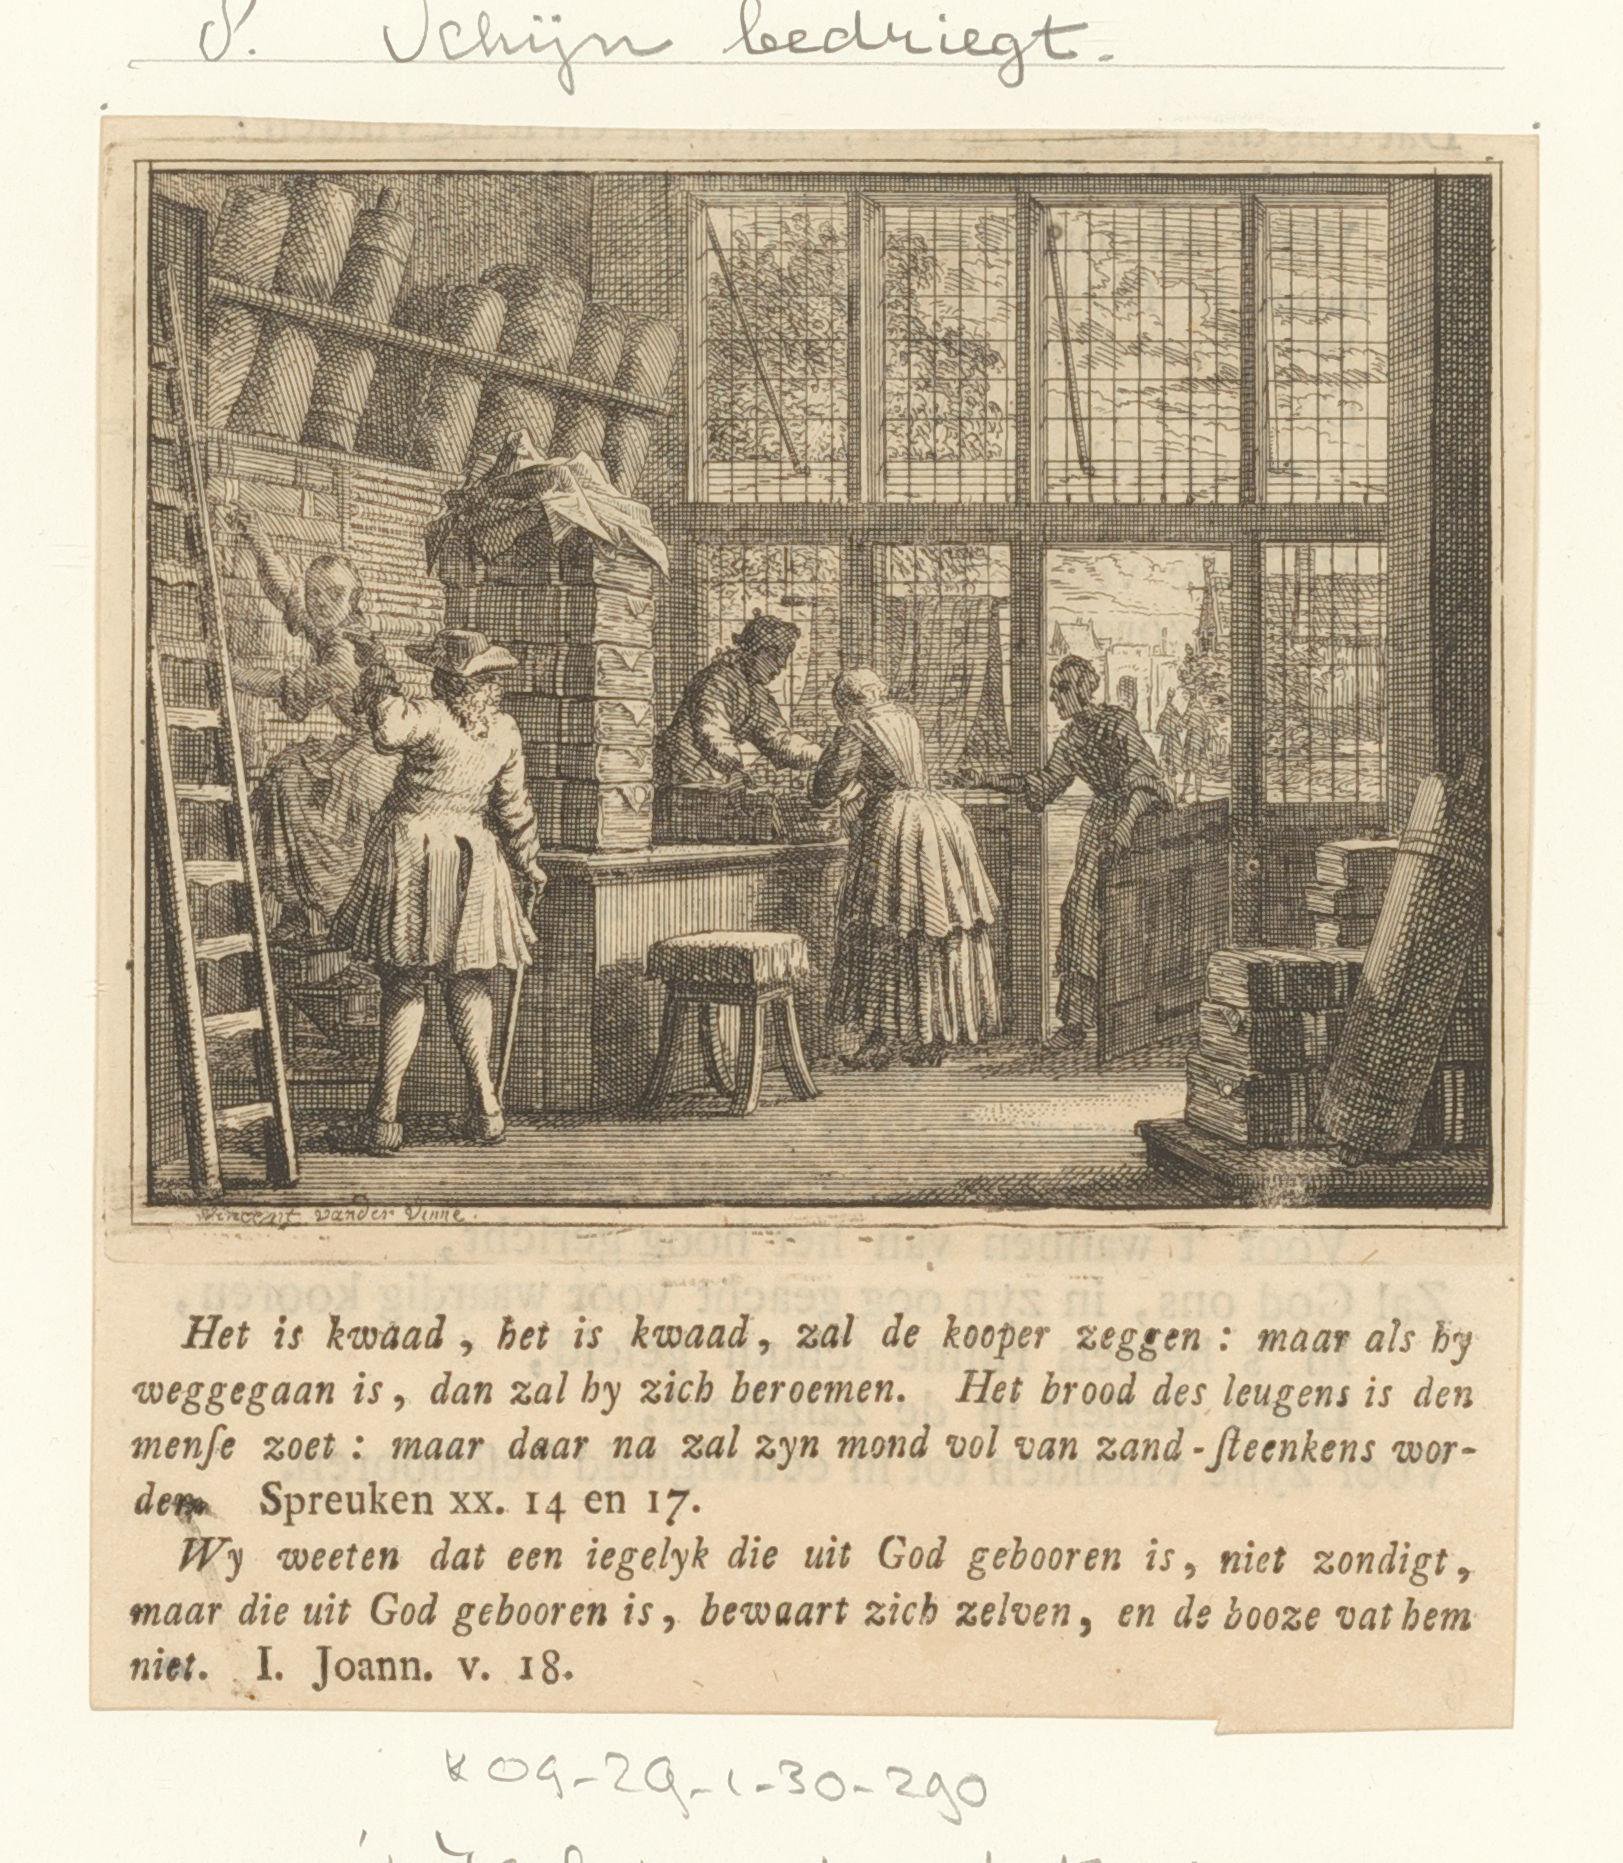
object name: print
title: Werkzaamheden bij een boekverkoper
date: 1758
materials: paper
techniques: etching, letterpress printing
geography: haarlem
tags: shop, store, counter ~ shop, book, proverbs, sayings, etc.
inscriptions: collector's mark: Lugt 1641, stamp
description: Embleem bij het motto: Schijn bedriegt. Onderaan een zevenregelige tekst in het Nederlands. Onderwerpsrubrieken binnen de Atlas Zeden en Gewoonten: Zeden en Gewoonten in engeren zin. Volksleven. Zinnebeeldige voorstellingen uit het volkleven op serieprenten. Maanden en diversen (allegorieën).